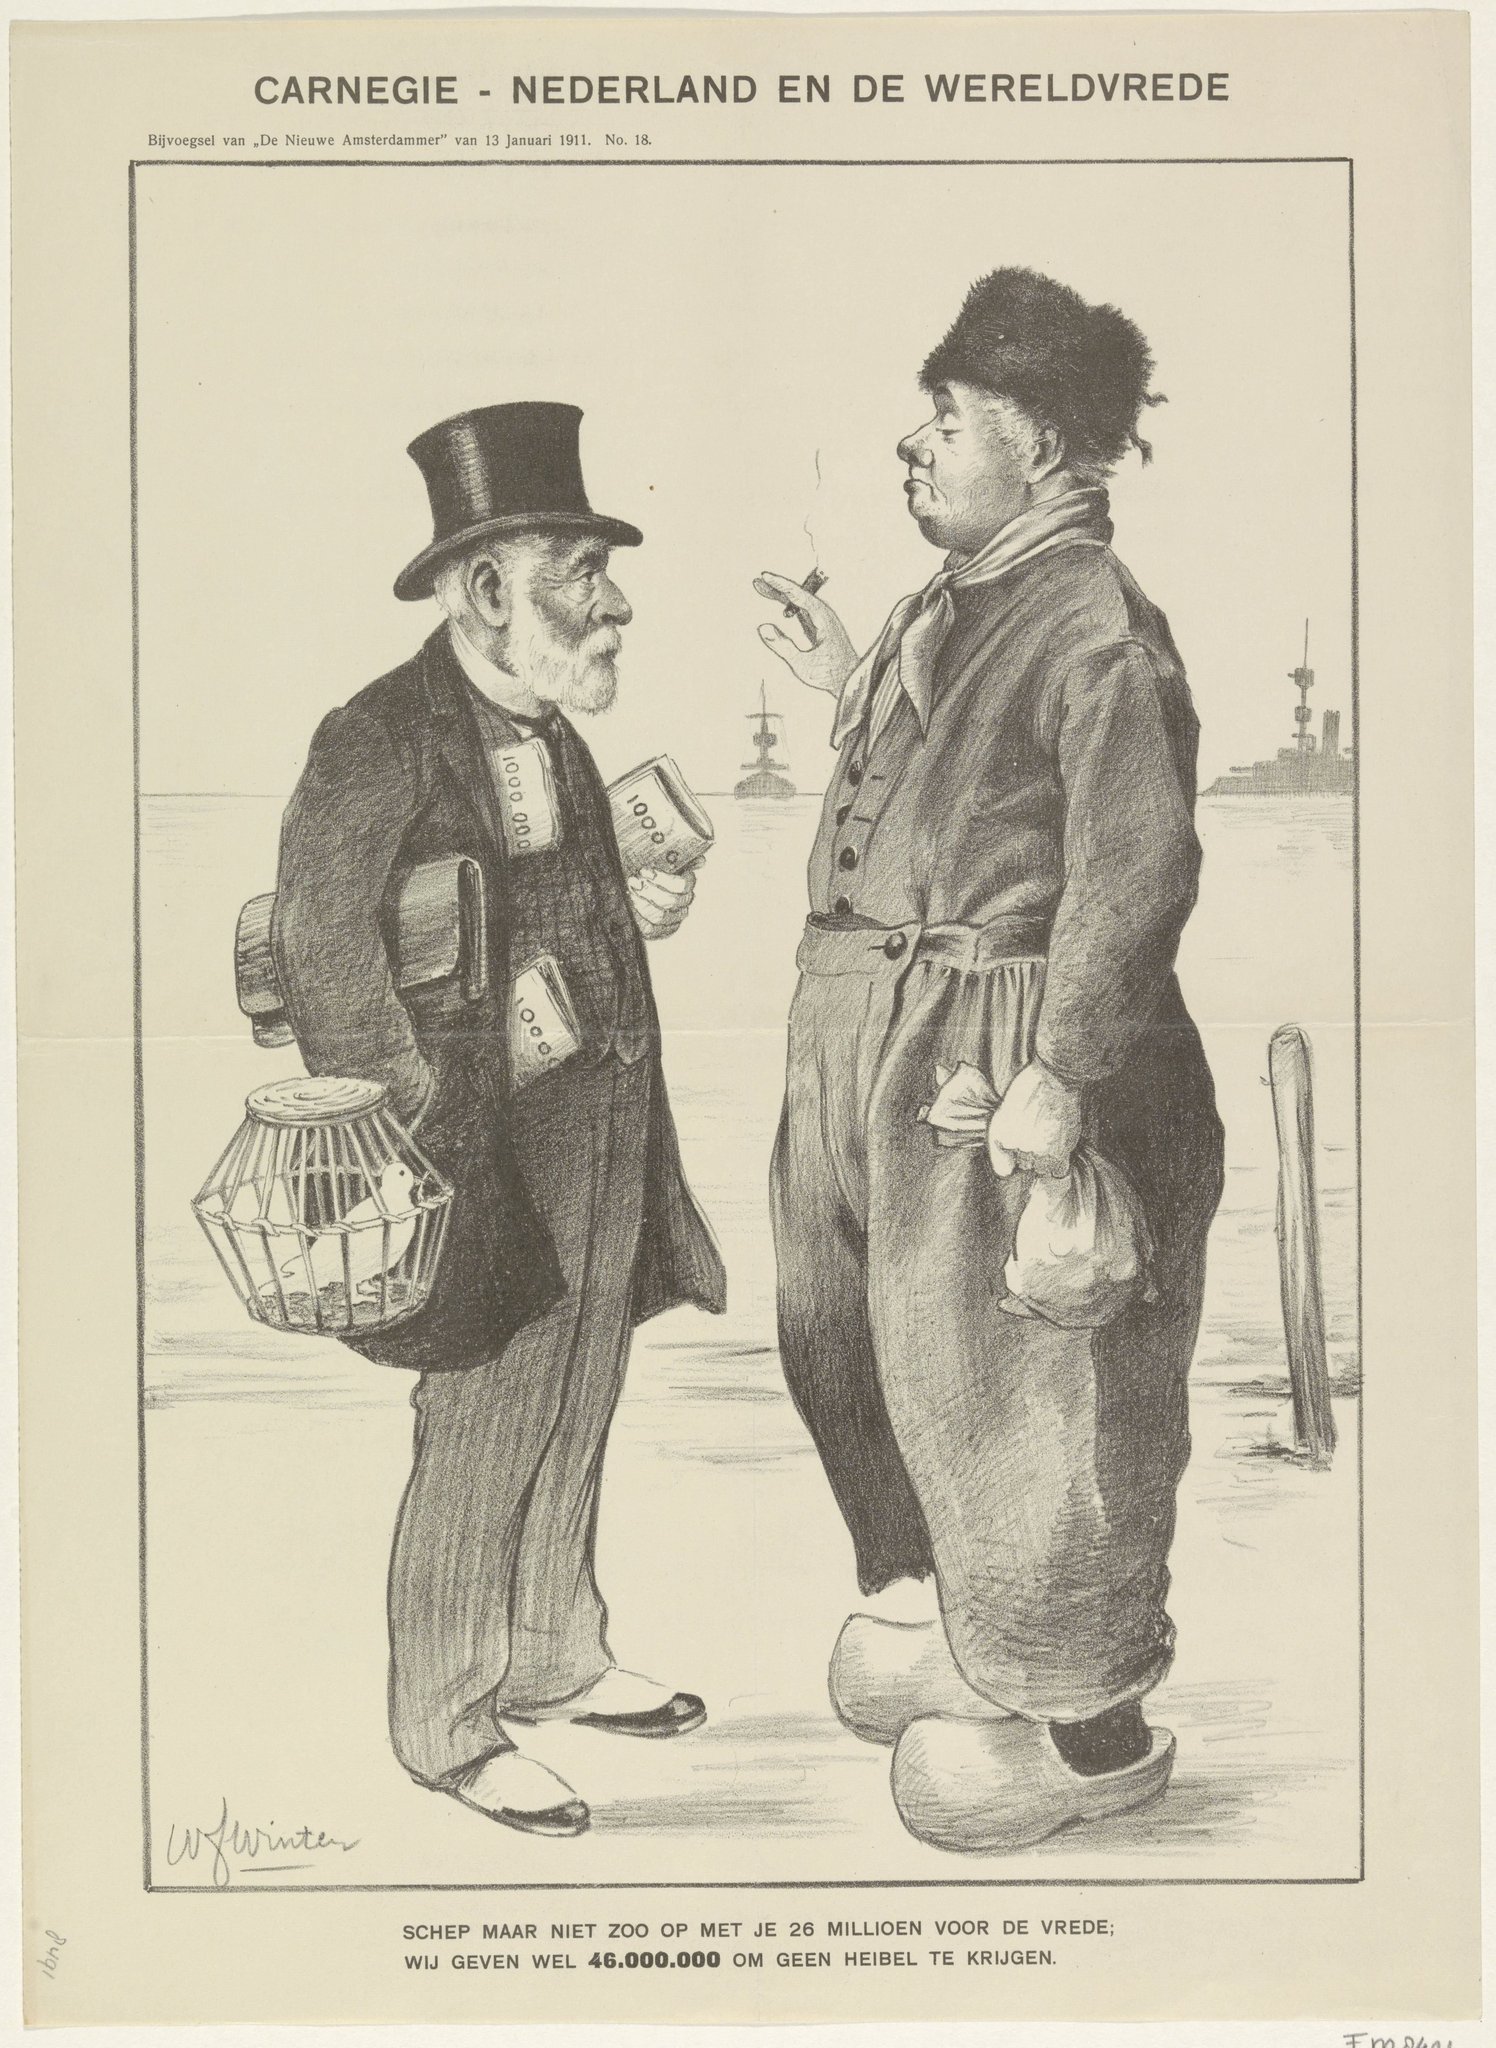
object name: cartoon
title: Carnegie - Nederland en de wereldvrede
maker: willem frederik winter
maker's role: draughtsman, painter, print maker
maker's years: 1874-1958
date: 1911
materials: paper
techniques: lithograph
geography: netherlands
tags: filantroop, andrew carnegie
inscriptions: collector's mark: Lugt 2228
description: Spotprent waarin de Amerikaanse zakenman Andrew Carnegie en een Nederlandse visser tegenover elkaar staan. Op de achtergrond oorlogsschepen op zee. Verschenen als bijvoegsel van de Nieuwe Amsterdammer van 13 januari 1911, no. 18.